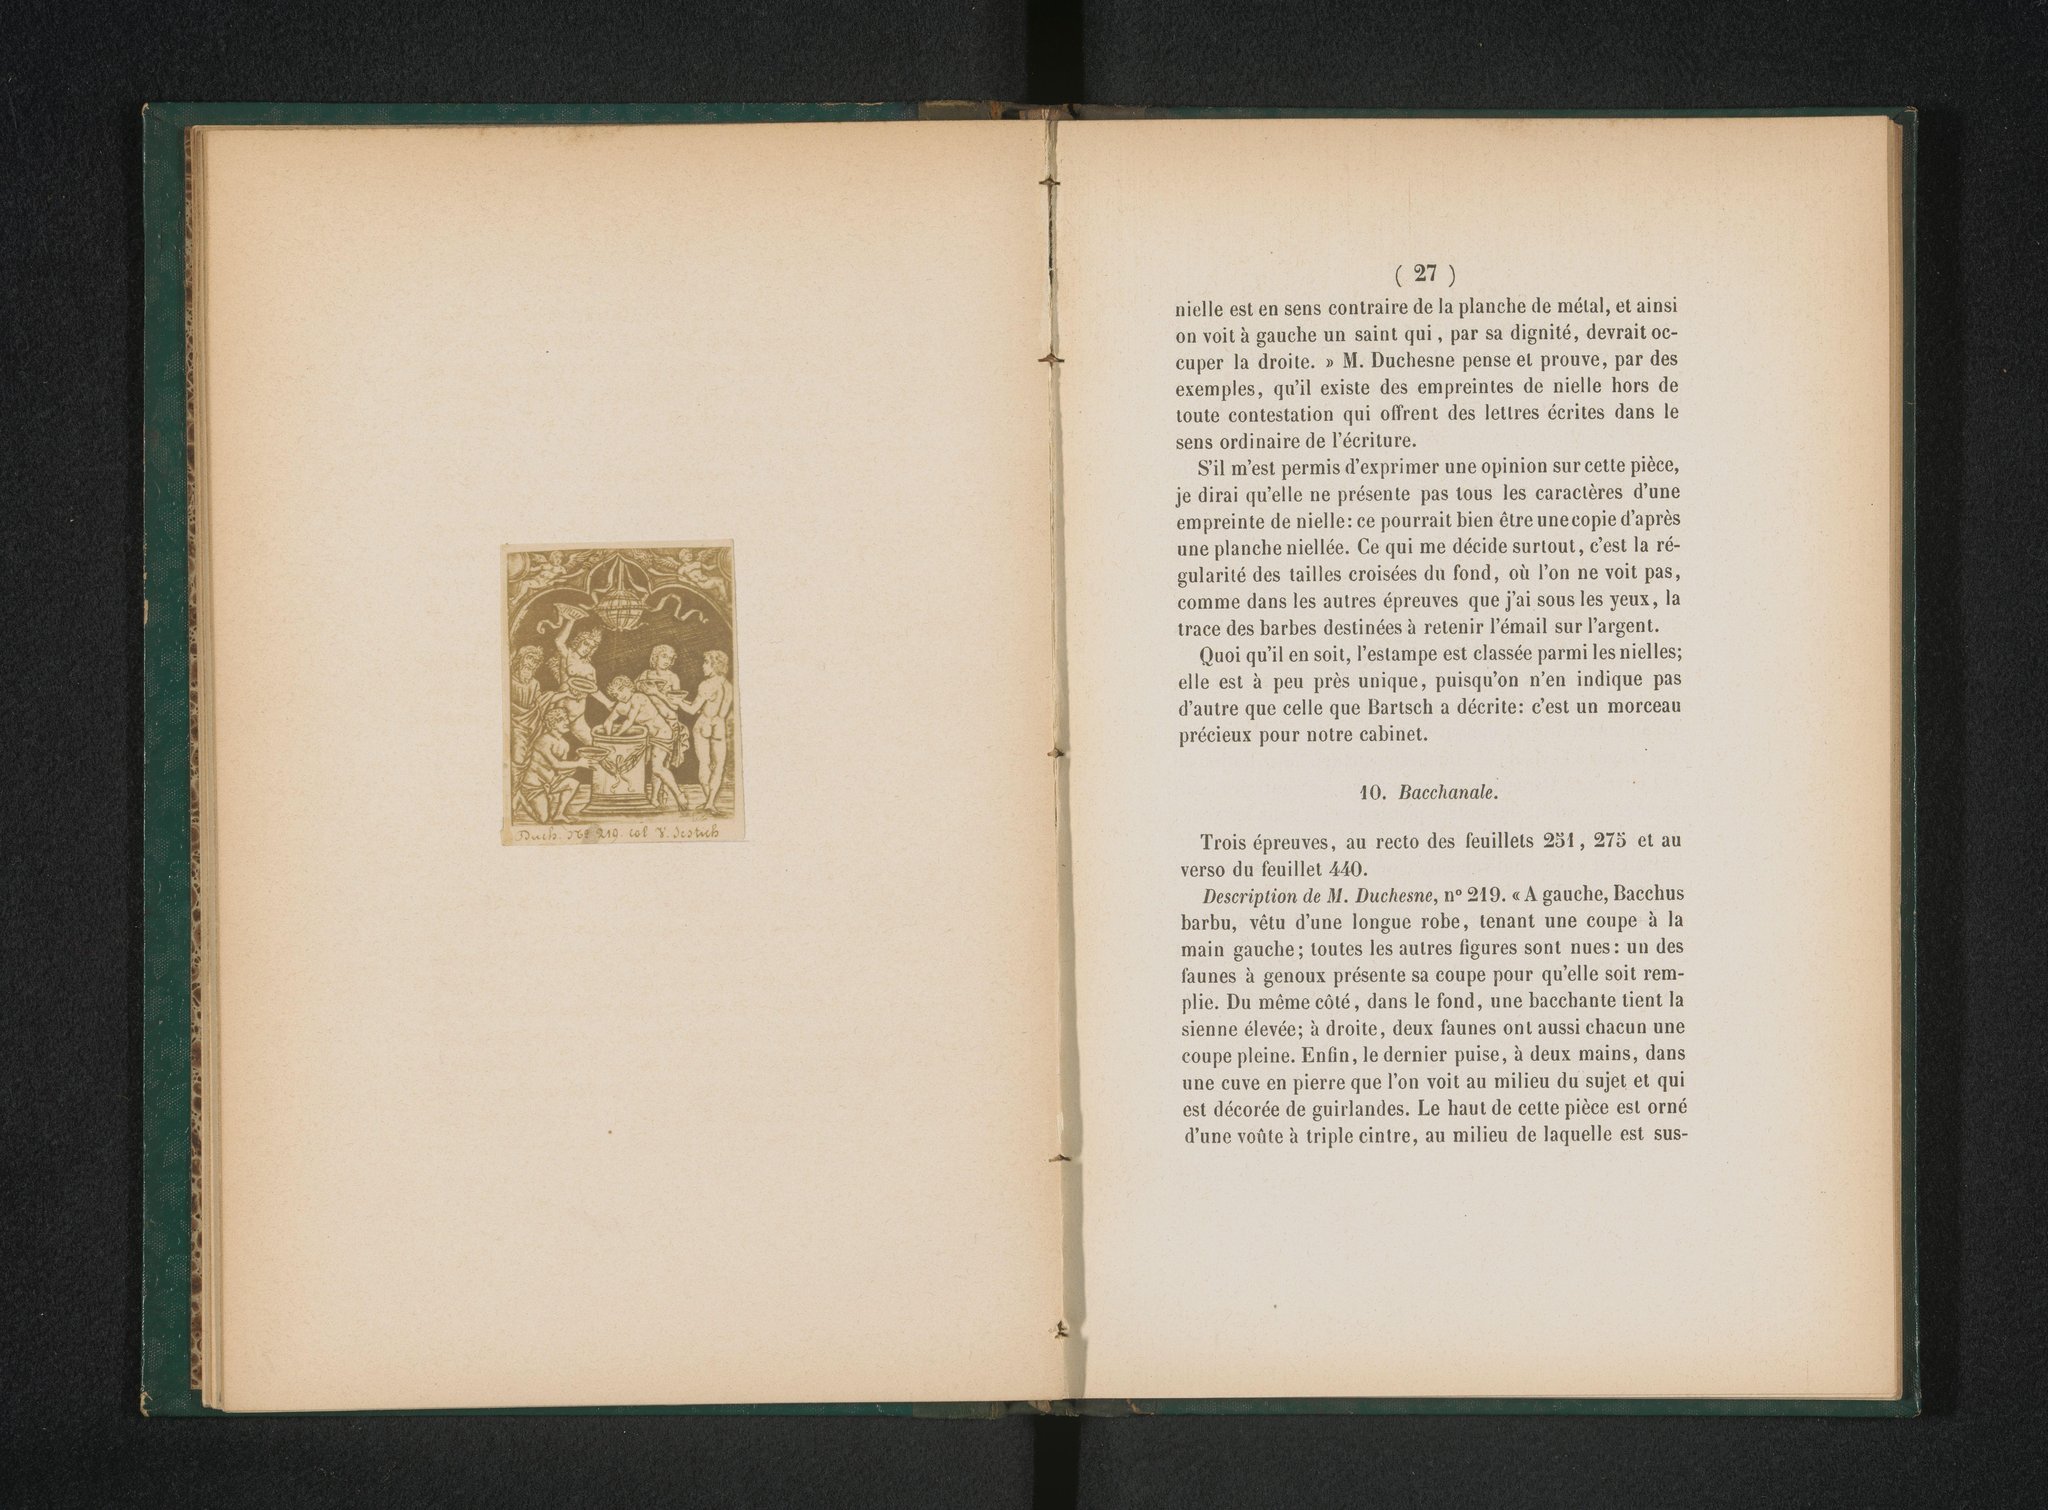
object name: page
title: Fotoreproductie van een prent van een bacchanaal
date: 1852-1857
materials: photographic support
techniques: salted paper print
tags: bacchanal: bacchus with his wine-flushed train (thiasos)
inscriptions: inscription: ‘Duch. No 219. col V. Sestich’